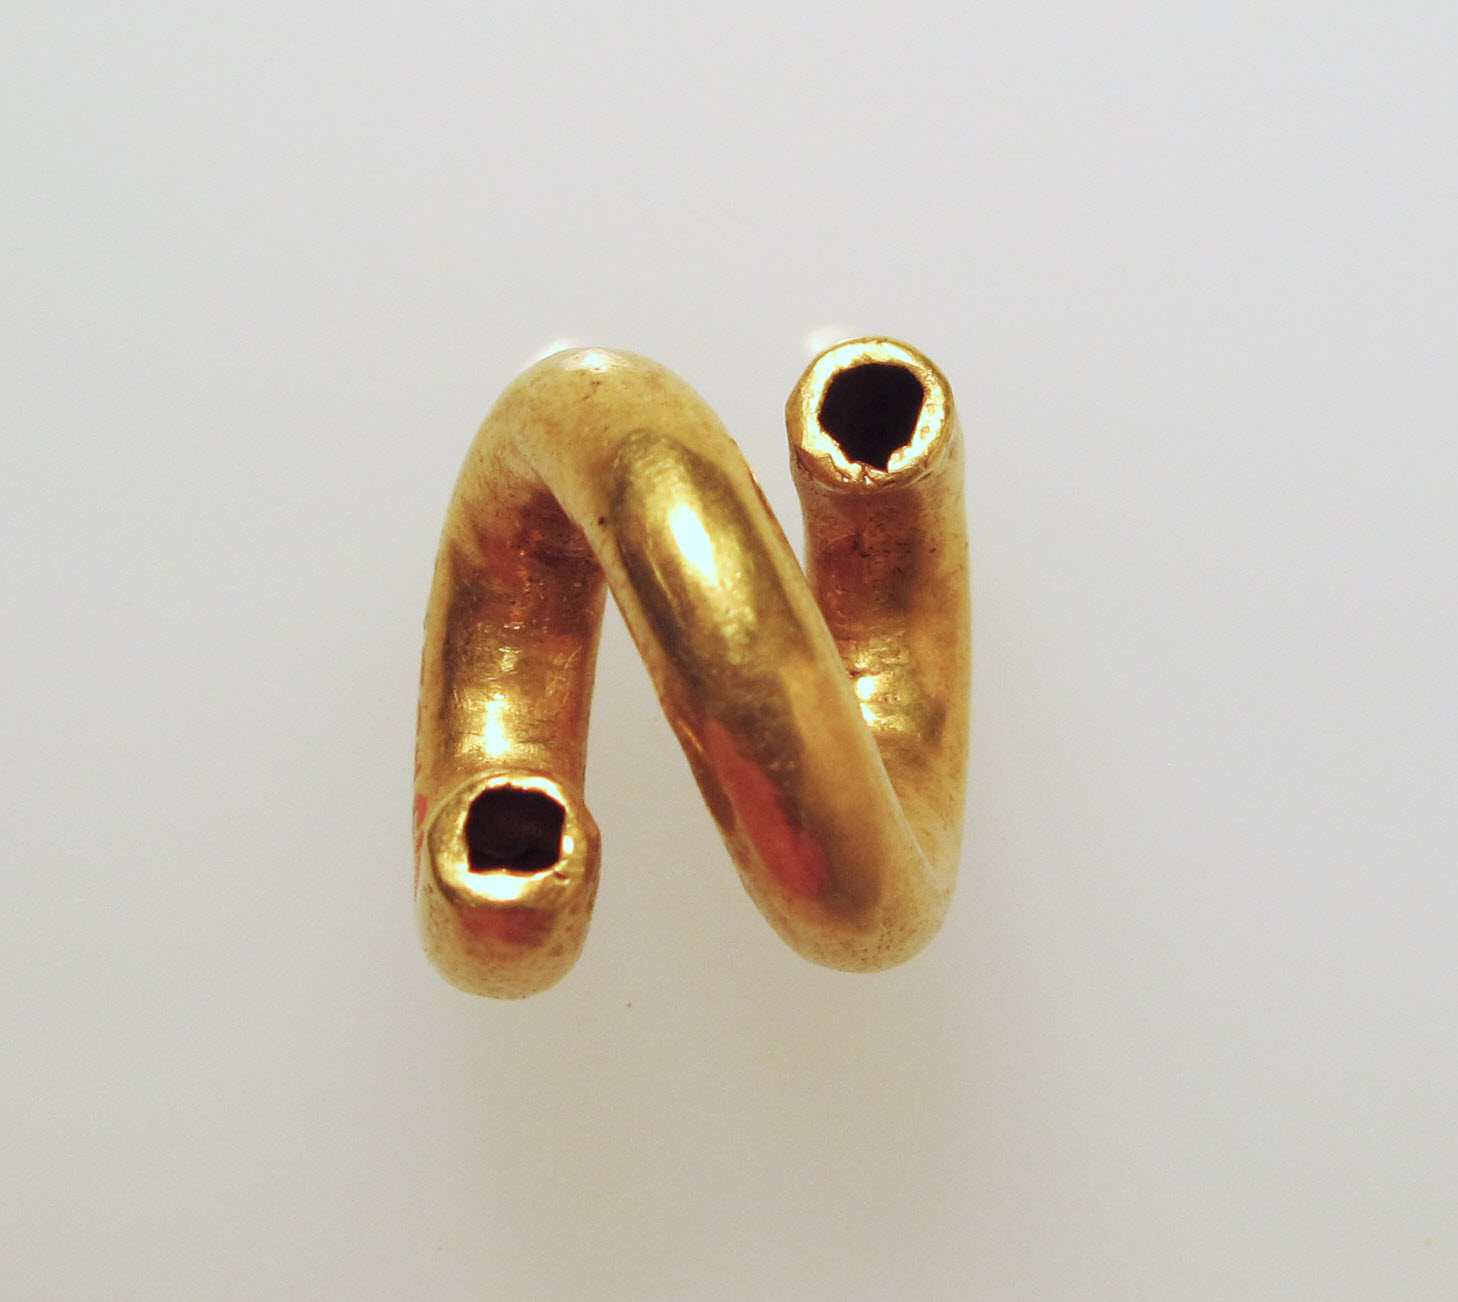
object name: earring or spiral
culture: cypriot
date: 600-301 BCE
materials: bronze, gold